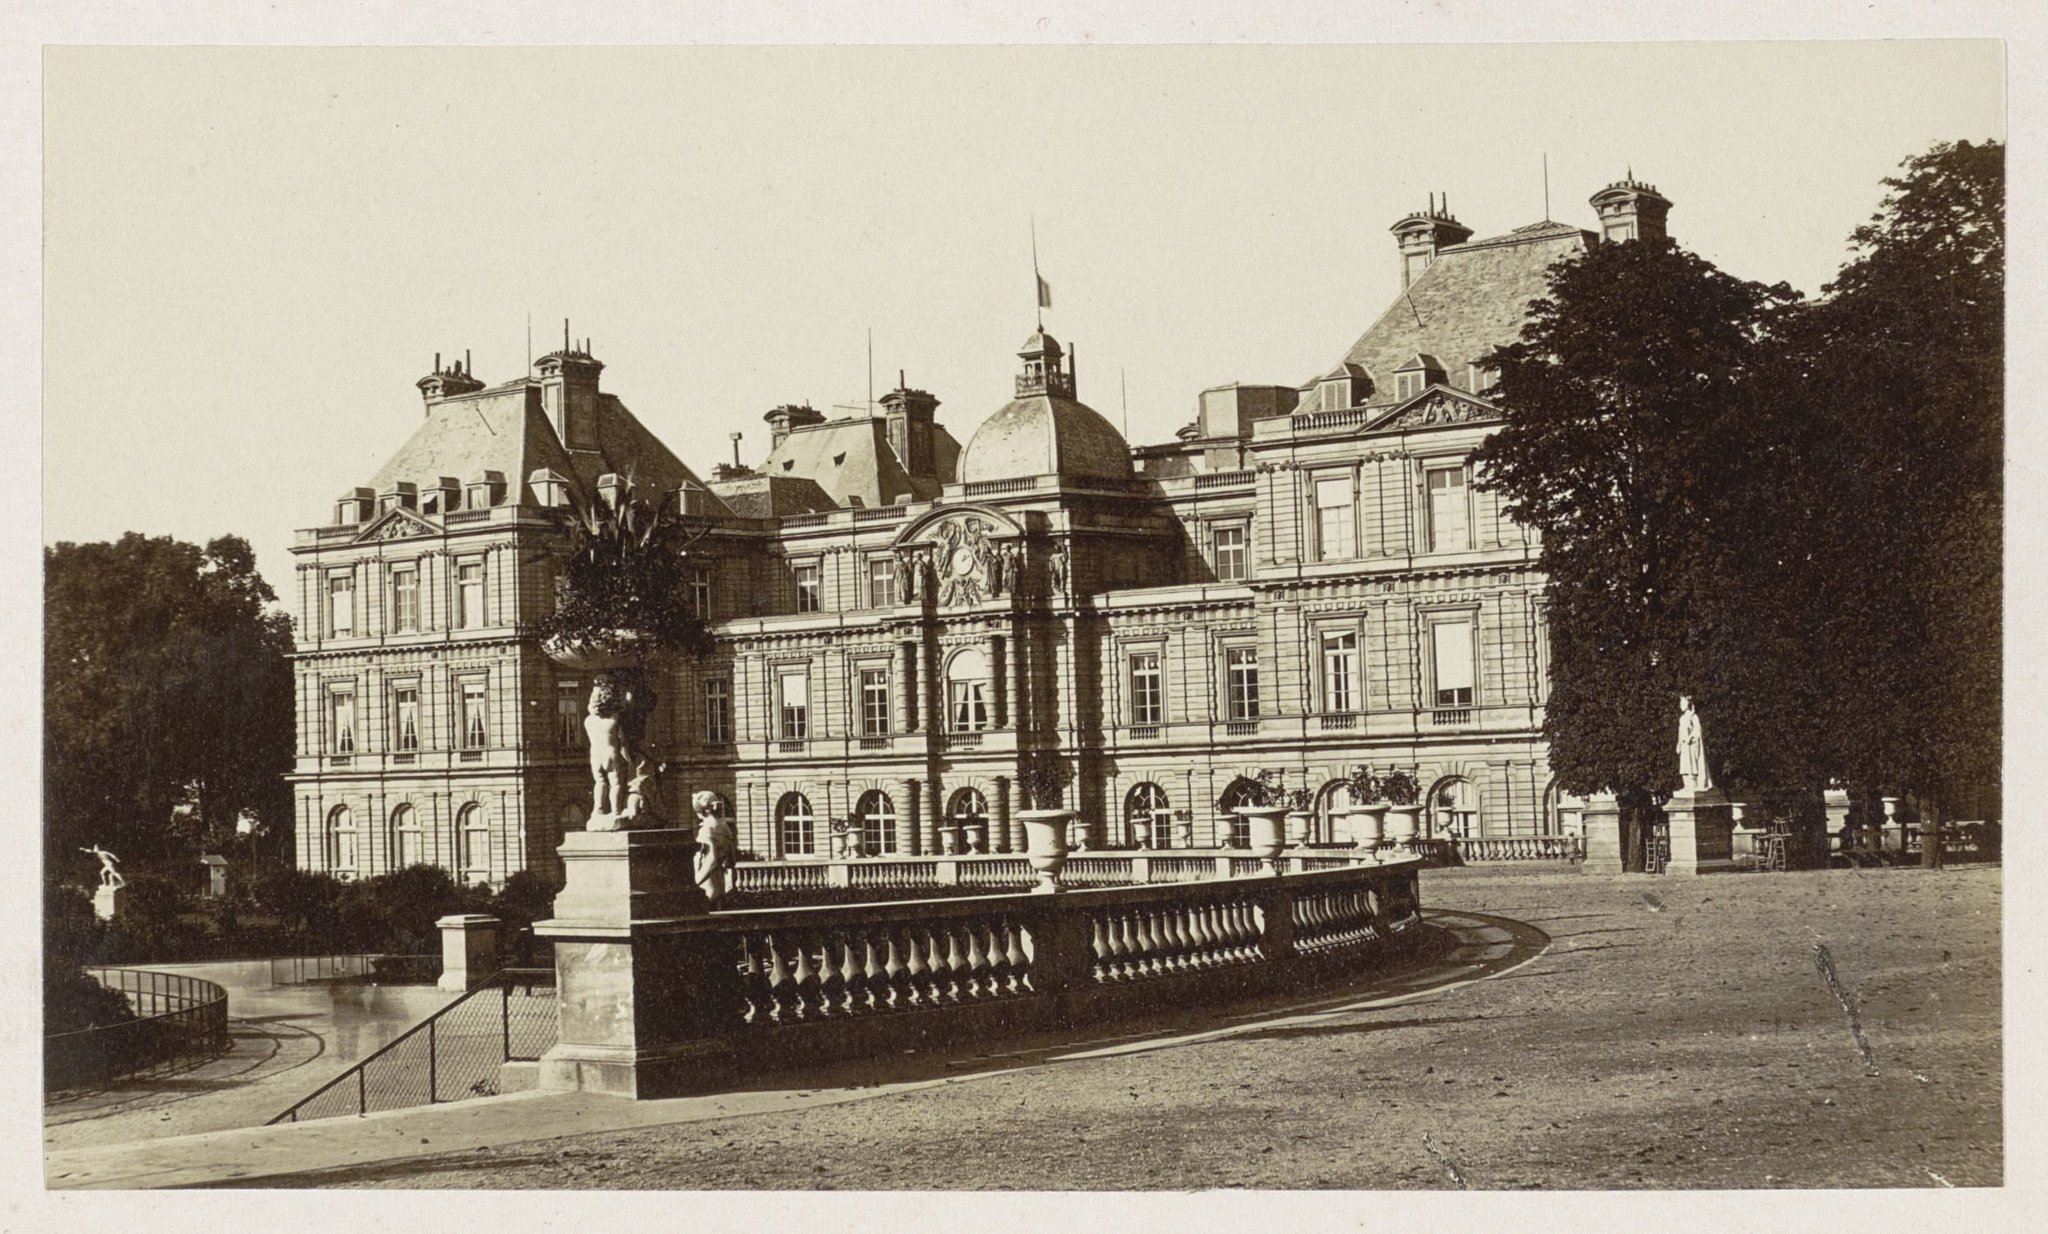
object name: photograph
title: Exterieur van het Palais du Luxembourg in Parijs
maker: Anonymous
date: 1878-1890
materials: photographic support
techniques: albumen print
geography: paris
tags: palace, façade (of house or building), paris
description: Onderdeel van Reisalbum Europese steden, vermoedelijk Zweeds.